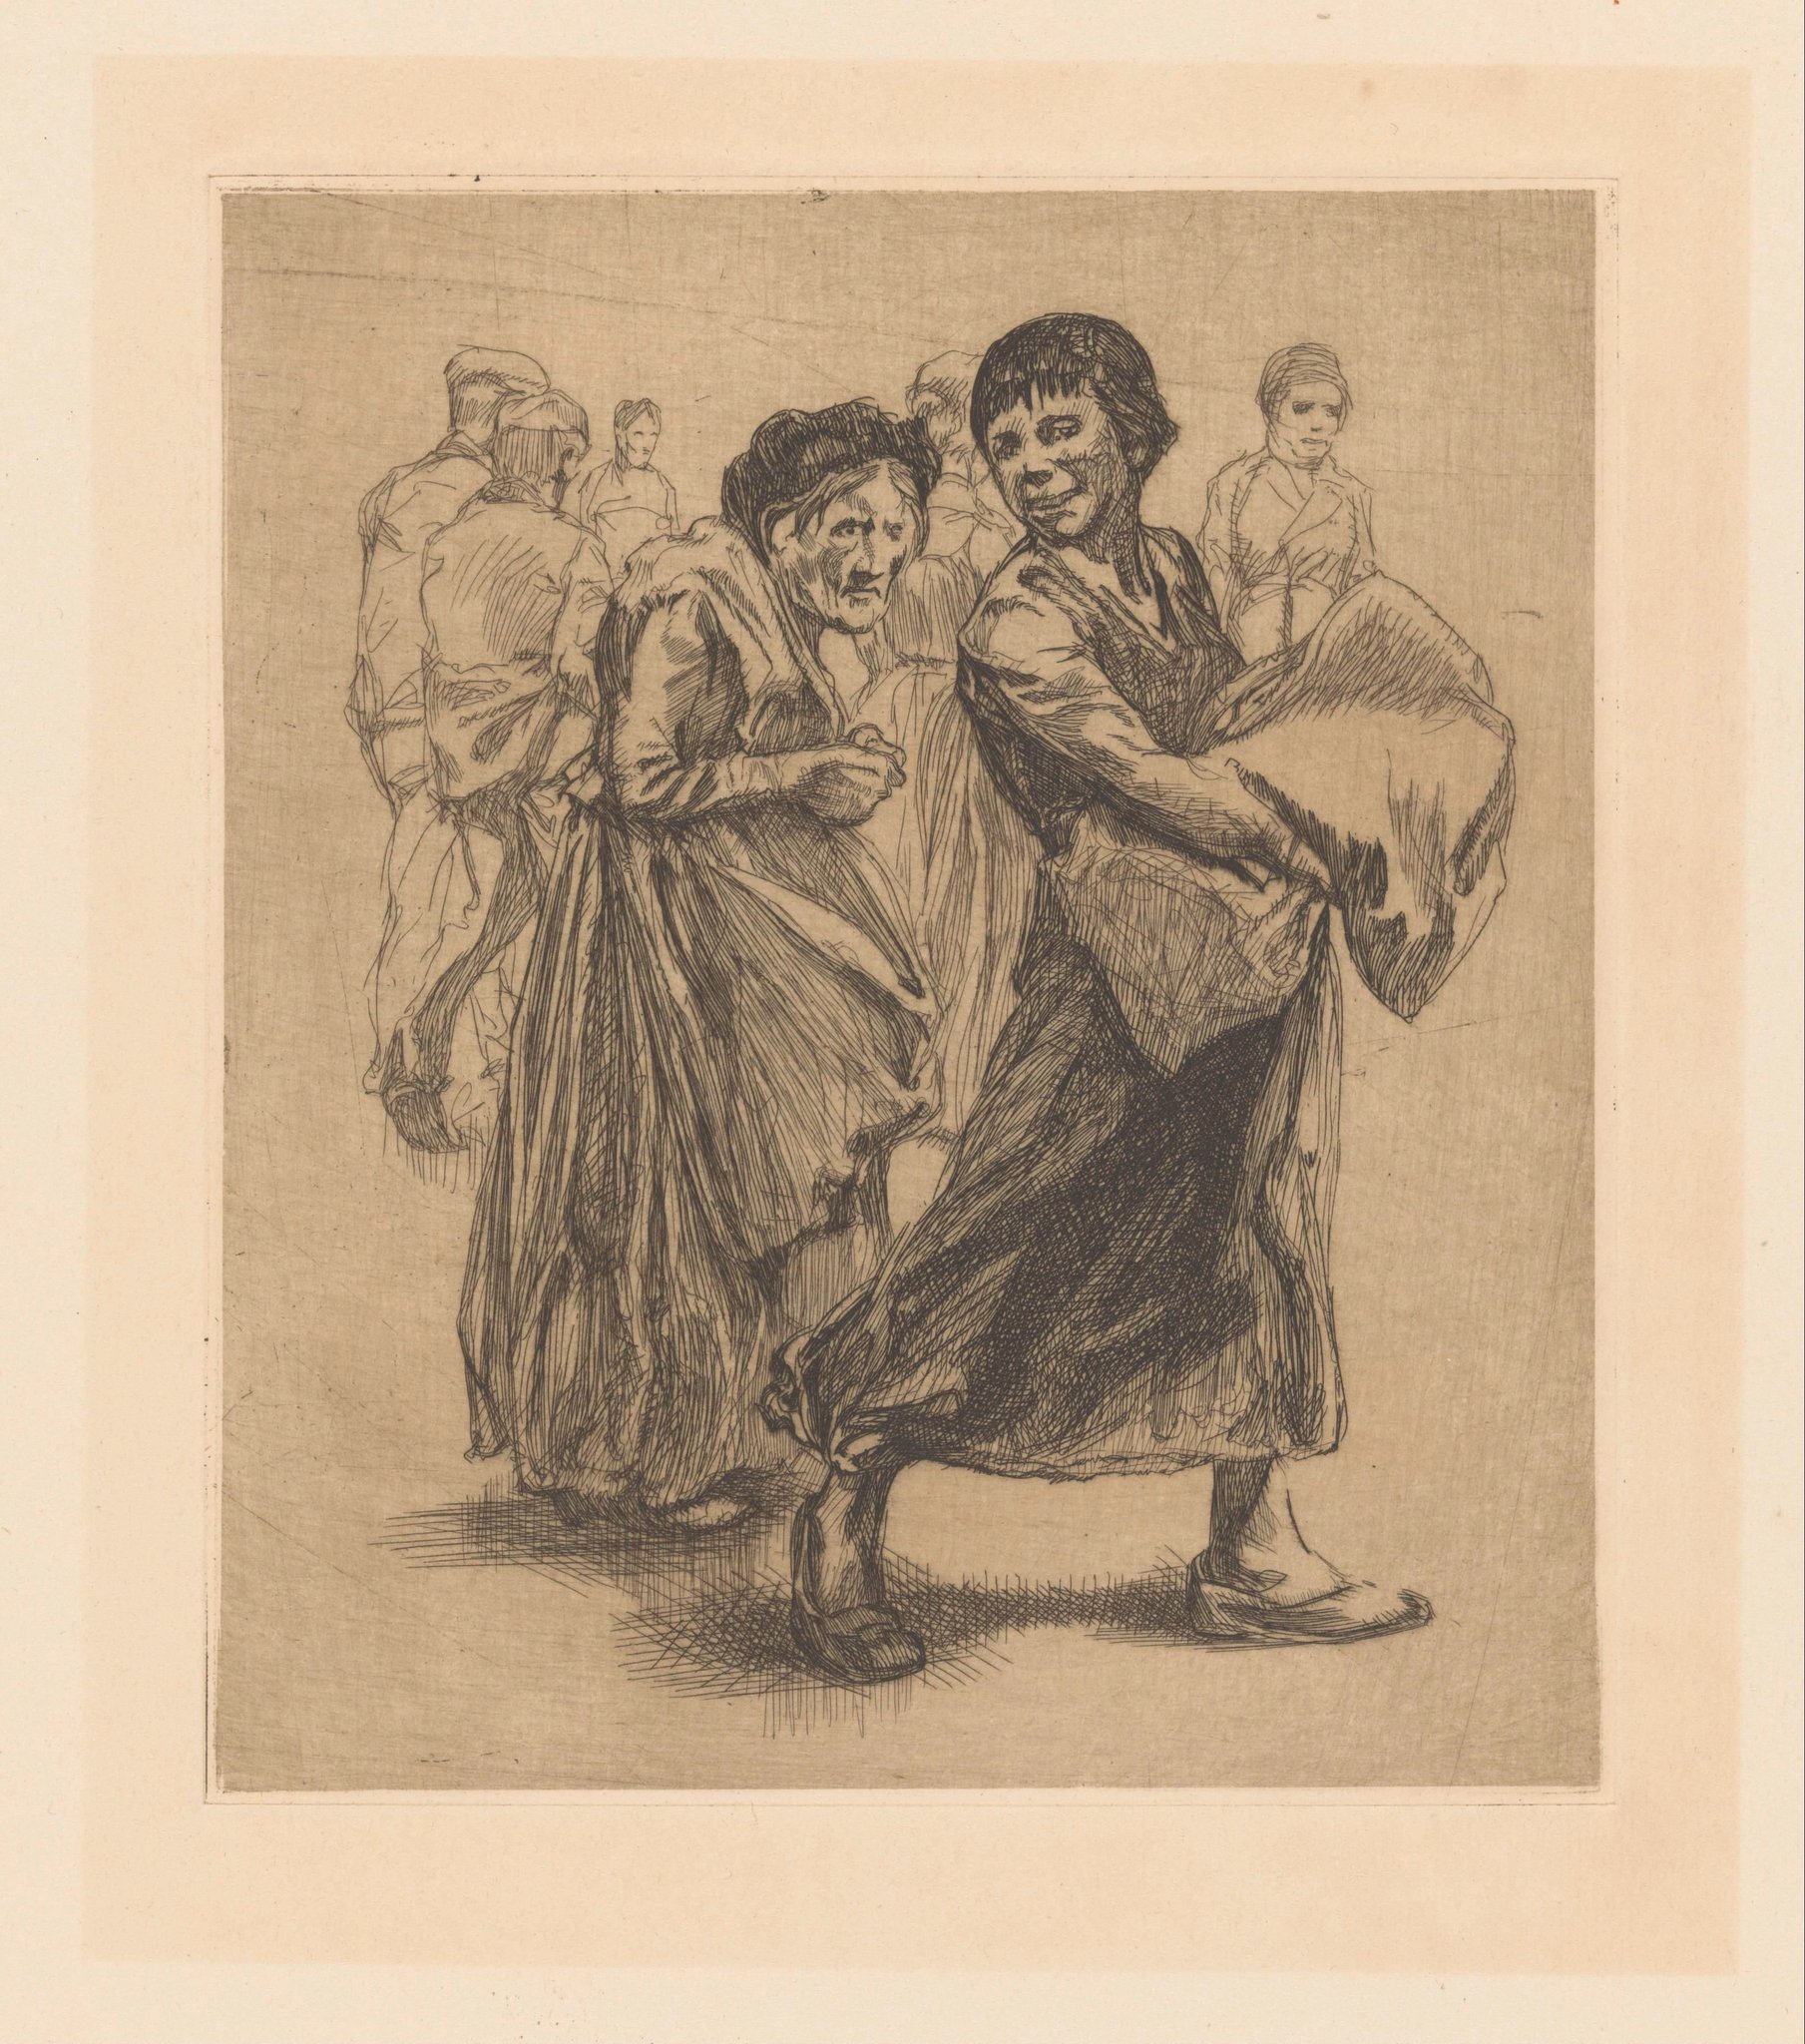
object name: print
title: Volkstypen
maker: johannes josephus aarts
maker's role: draughtsman, print maker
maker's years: 1871-1934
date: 1881-1934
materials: paper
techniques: etching, intaglio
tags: container of textile material: bag, sack, crooked, bent person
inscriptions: collector's mark: Lugt 2228, collector's mark: Lugt 2760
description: Een vrouw loopt met een zak in haar armen. Naast haar een vrouw met kromme rug. Op de achtergrond nog vijf andere figuren.